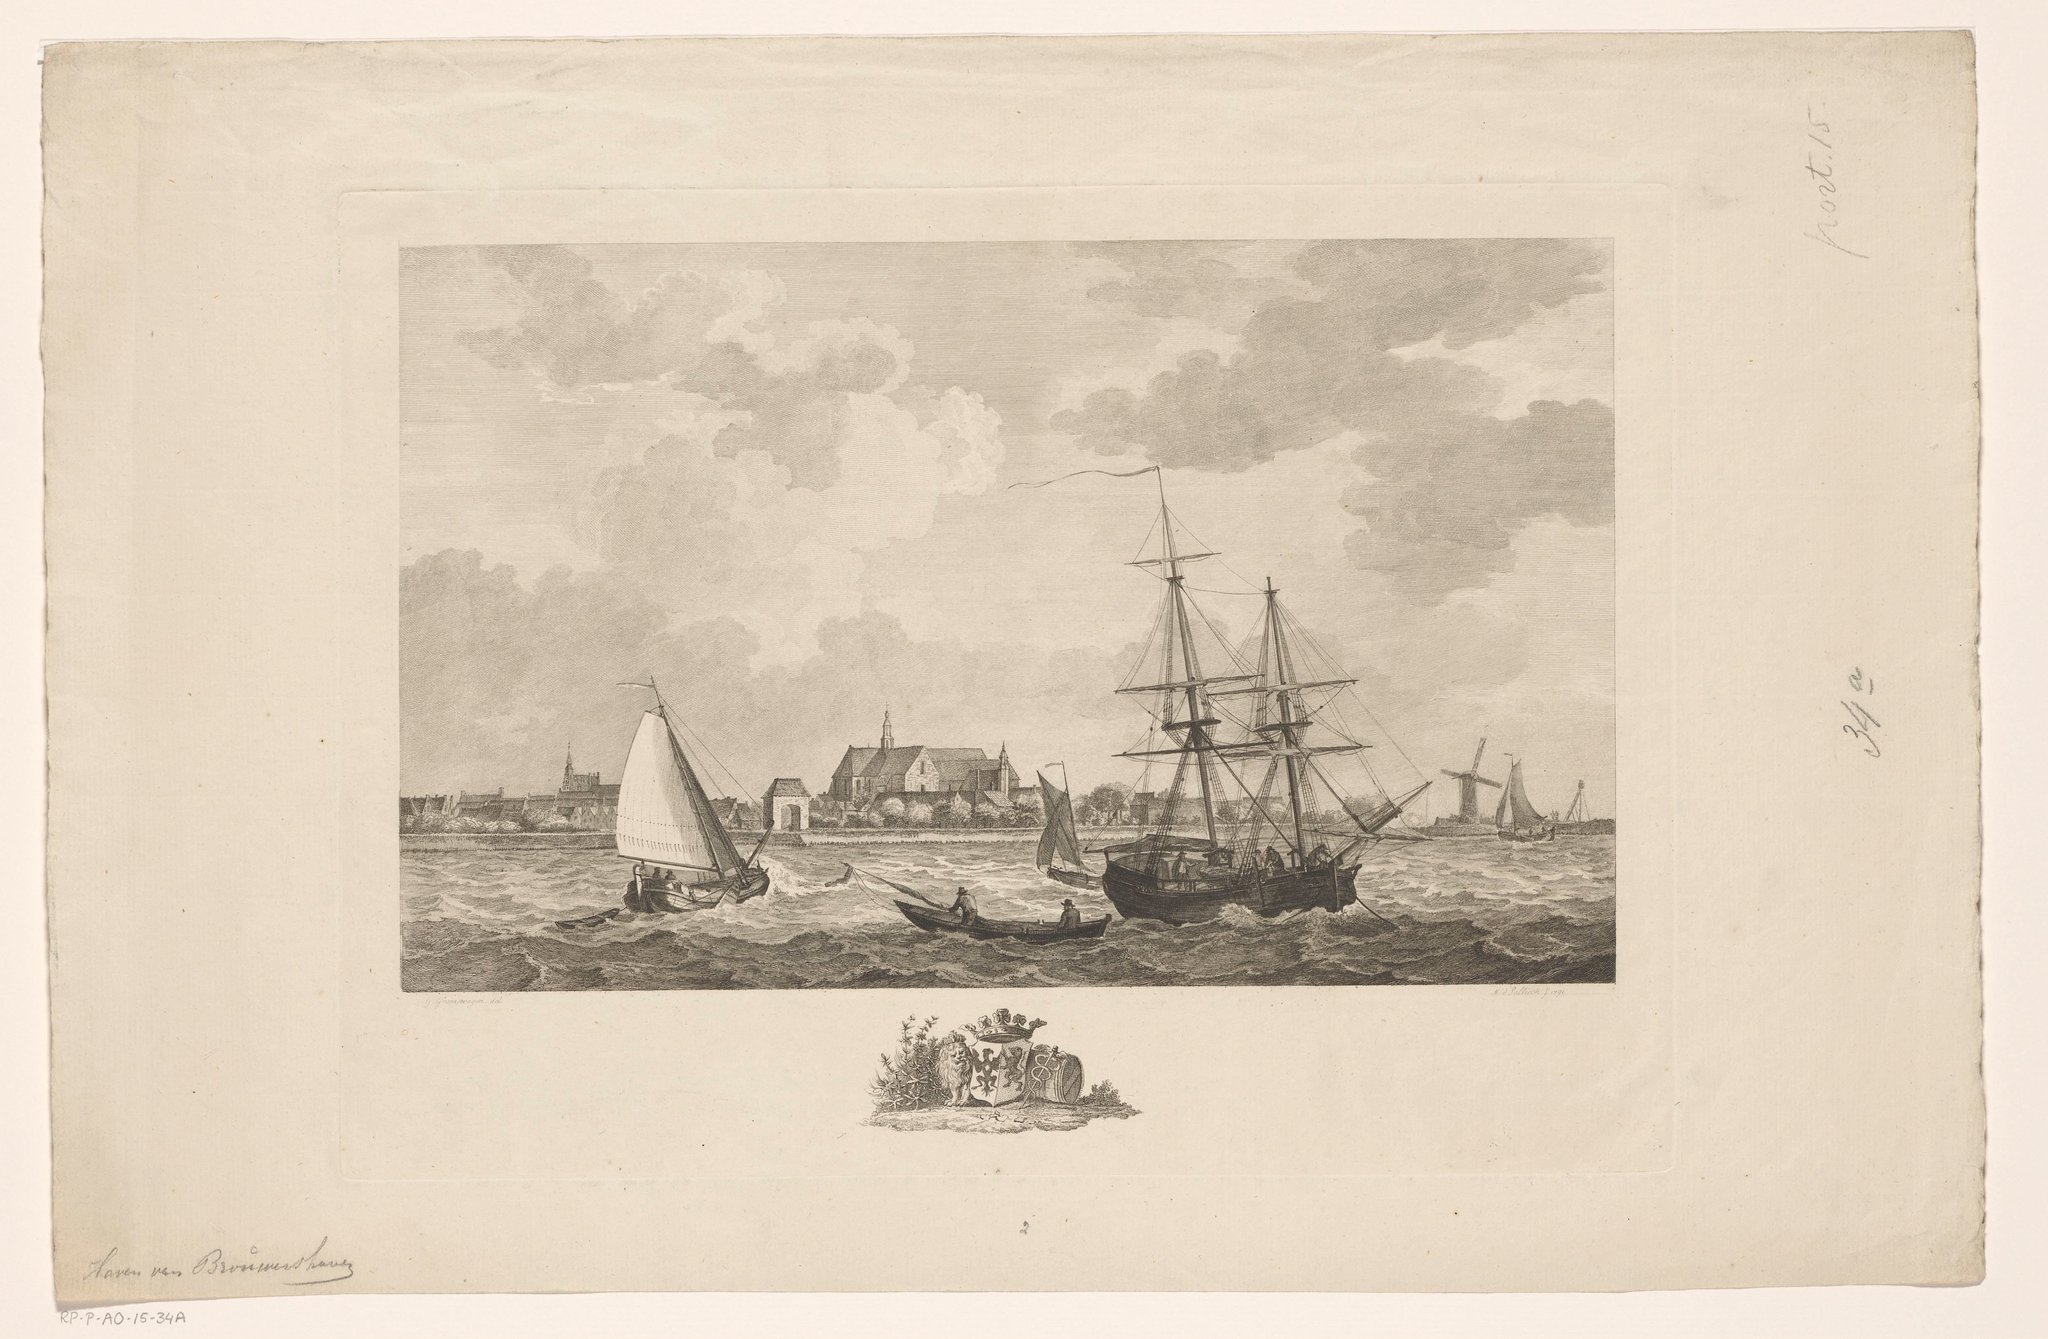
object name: print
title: Gezicht op de haven van Brouwershaven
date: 1764-1787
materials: paper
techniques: engraving, etching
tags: harbour, coat of arms (as symbol of the state, etc.) (+ city; municipal), sailing-ship, sailing-boat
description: Zie RP-P-AO-15-139 voor latere staat. Nog latere staat ook gebruikt in: Aa, Cornelis van der. Atlas van de zeehavens der Bataafsche Republiek. Met derzelver beschrijvingen in XXXI kunstplaaten / Atlas van de zeehavens der Bataafsche Republiek, die van Batavia en Onrust. Mitsgaders de afbeeldingen van de haringvisscherij en de walvischvangst (…). Amsterdam: Evert Maaskamp, 1805. De datering 1791 in de marge rechts, onder de voorstelling, klopt niet. P. (Pieter / Pierre) Yver, een van uitgevers vermeld op de latere staat RP-P-1905-771, is namelijk overleden in 1787. Hij heeft ook geen zoon of ander familielid met de voorletter P nagelaten om zijn uitgeverij voort te zetten, dus het kan niet om een andere P. Yver gaan.